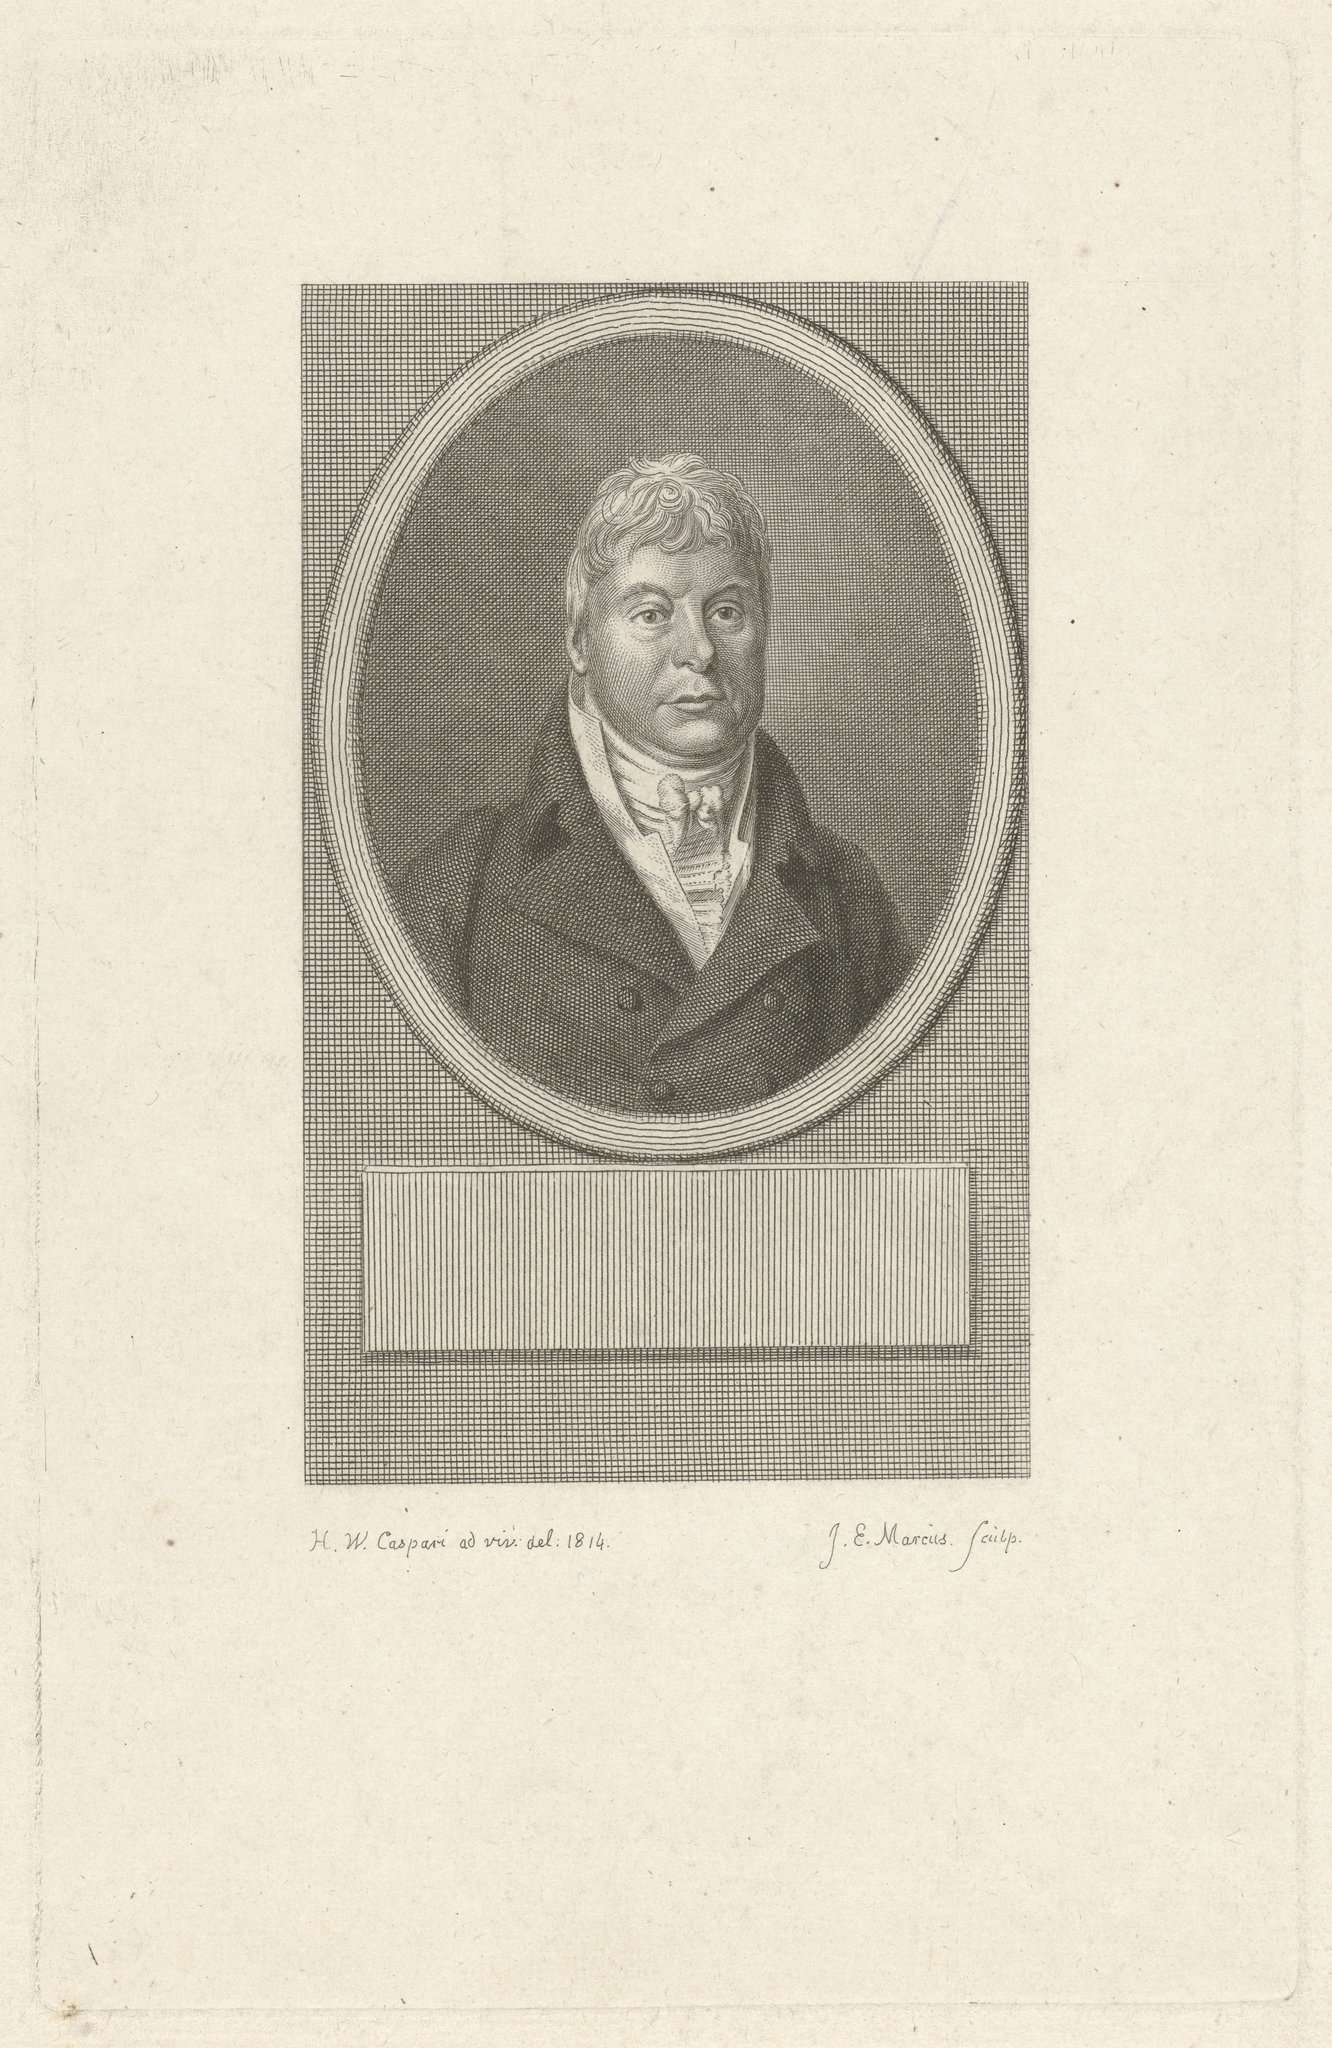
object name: print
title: Portret van François Daniel Changuion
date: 1814-1817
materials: paper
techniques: engraving, etching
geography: amsterdam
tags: secretaris, françois daniel changuion, stichting van het koninkrijk der nederlanden (1813)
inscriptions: collector's mark: Lugt 2228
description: Latere staat van de prent ook gebruikt in: Herman Bosscha, Geschiedenis der Nederlandsche staatsomwenteling in 1813. 4 dln. Amsterdam: P. den Hengt en zn. en J. van der Hey, 1817.